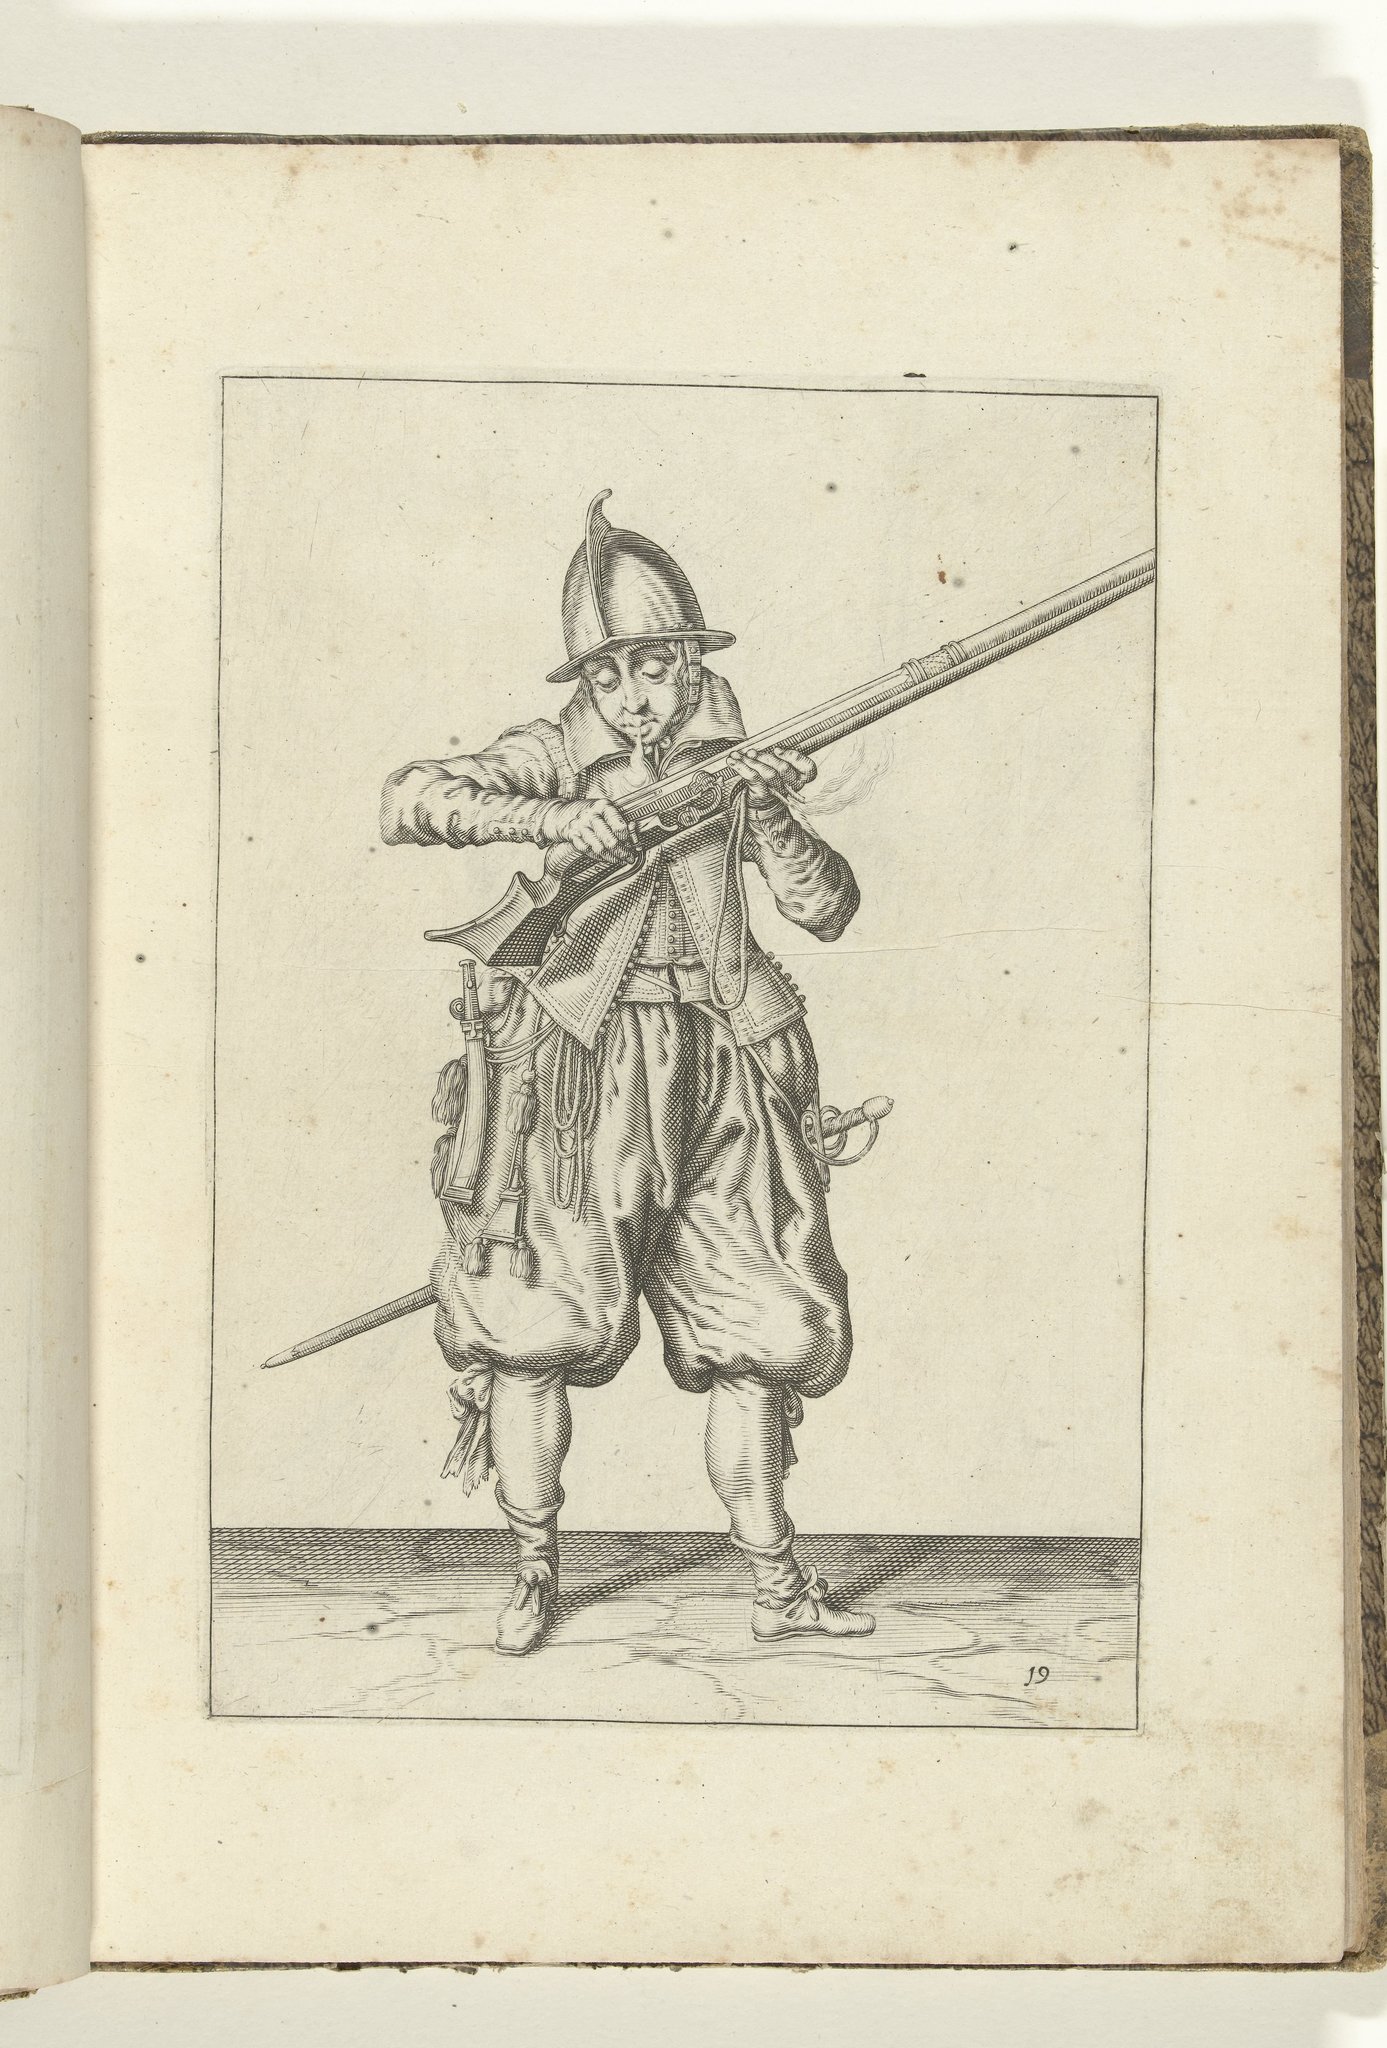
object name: print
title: Soldaat die kruit van zijn roer blaast (nr. 19), ca. 1600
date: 1597-1608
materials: paper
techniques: engraving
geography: amsterdam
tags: maurice (prince of orange), handling of weapons ~ military training, weapons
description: Een soldaat, ten voeten uit, die met beide handen een roer (een bepaald type vuurwapen) bij zijn mond houdt en erover blaast, om eventueel buiten de pan (het kruitreservoir) gevallen kruit ervan af te krijgen (nr. 19), ca. 1600. In zijn linkerhand behalve de loop van het roer ook een brandende lont. Plaat 19 in de instructies voor het hanteren van de roer: Brief enseignement, sur la representation des figures, du droit maniement de l'Harquebuse. Onderdeel van de illustraties in een Franse editie van J. de Gheyns Wapenhandelinghe: J. de Gheyn, Maniement d'armes, d'arquebuses, mousquetz et piques : en conformité de l'ordre de Mour le Prince Maurice, Prince d'Orange, Amsterdam 1608. Krijgswezen rond 1600.